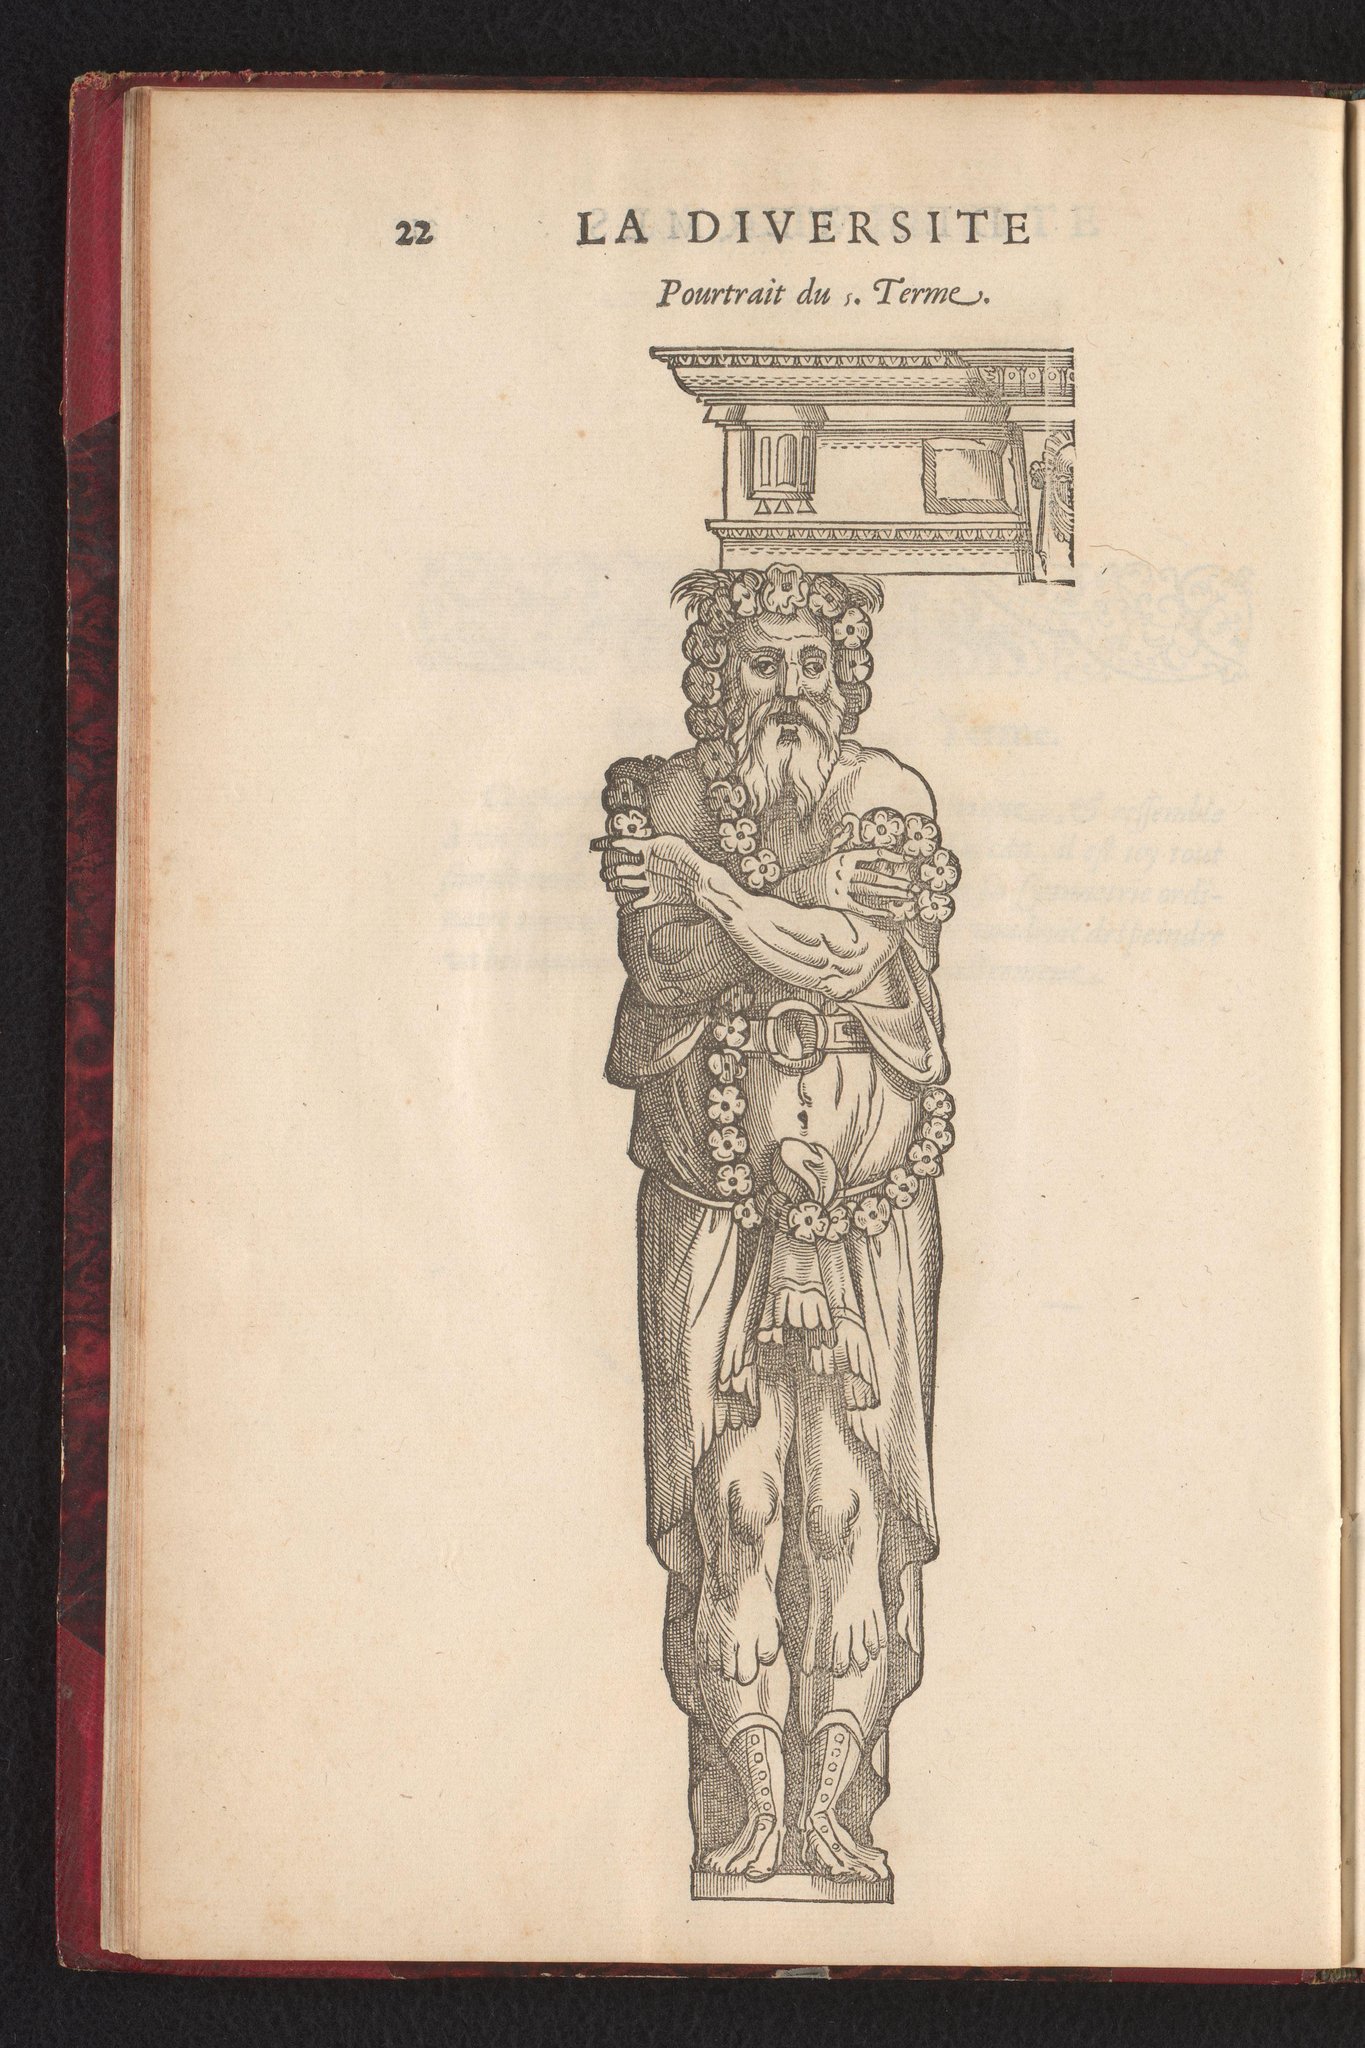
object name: album leaf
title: Mannelijke term met bloemenslingers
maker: Anonymous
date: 1572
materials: paper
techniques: letterpress printing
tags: herms (garden ornaments), pedestal of a piece of sculpture (perhaps in the form of a herm), herm: pillar with the head of mercury, patron of travellers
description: Linksboven genummerd: 22. Volgens de toelichting op pagina 22 gaat het hier om de Dorische orde. Prent maakt deel uit van een album.